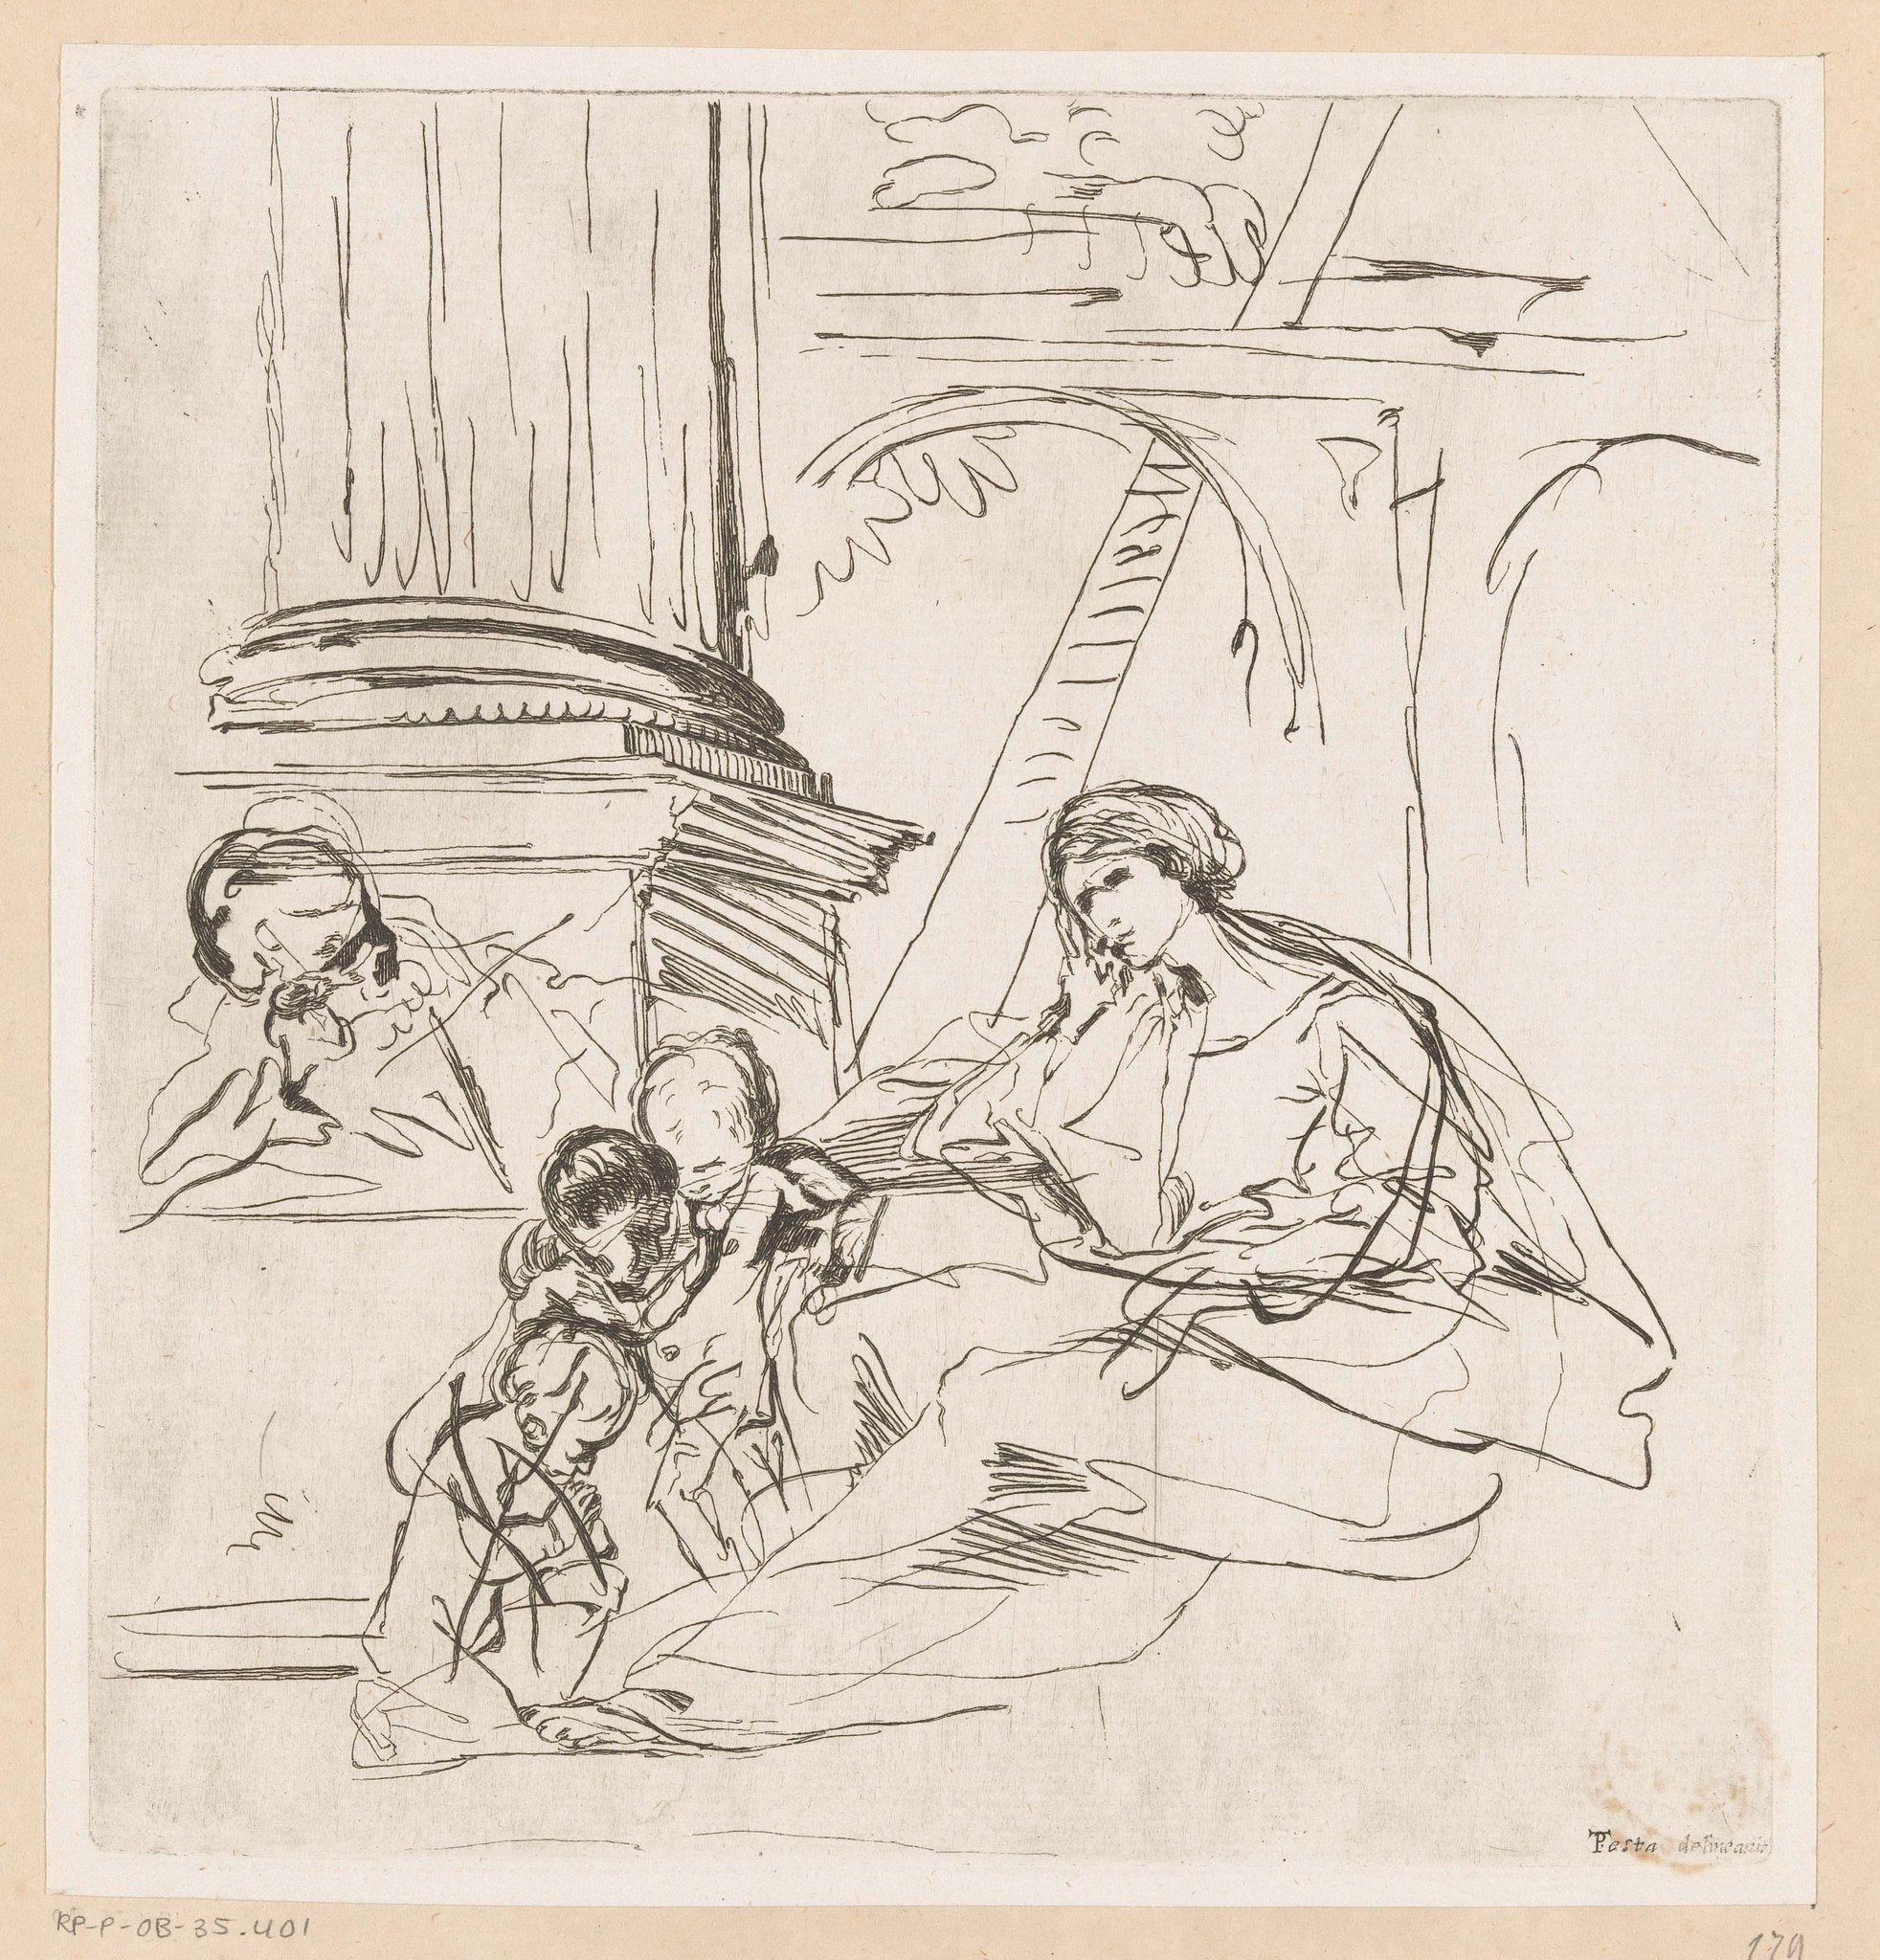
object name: print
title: Heilige Familie met twee kinderen erbij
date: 1650-1750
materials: paper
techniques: etching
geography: italy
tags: holy family, and derived representations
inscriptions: collector's mark: Lugt 240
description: De Heilige Familie met twee kinderen erbij voor een bouwwerk.